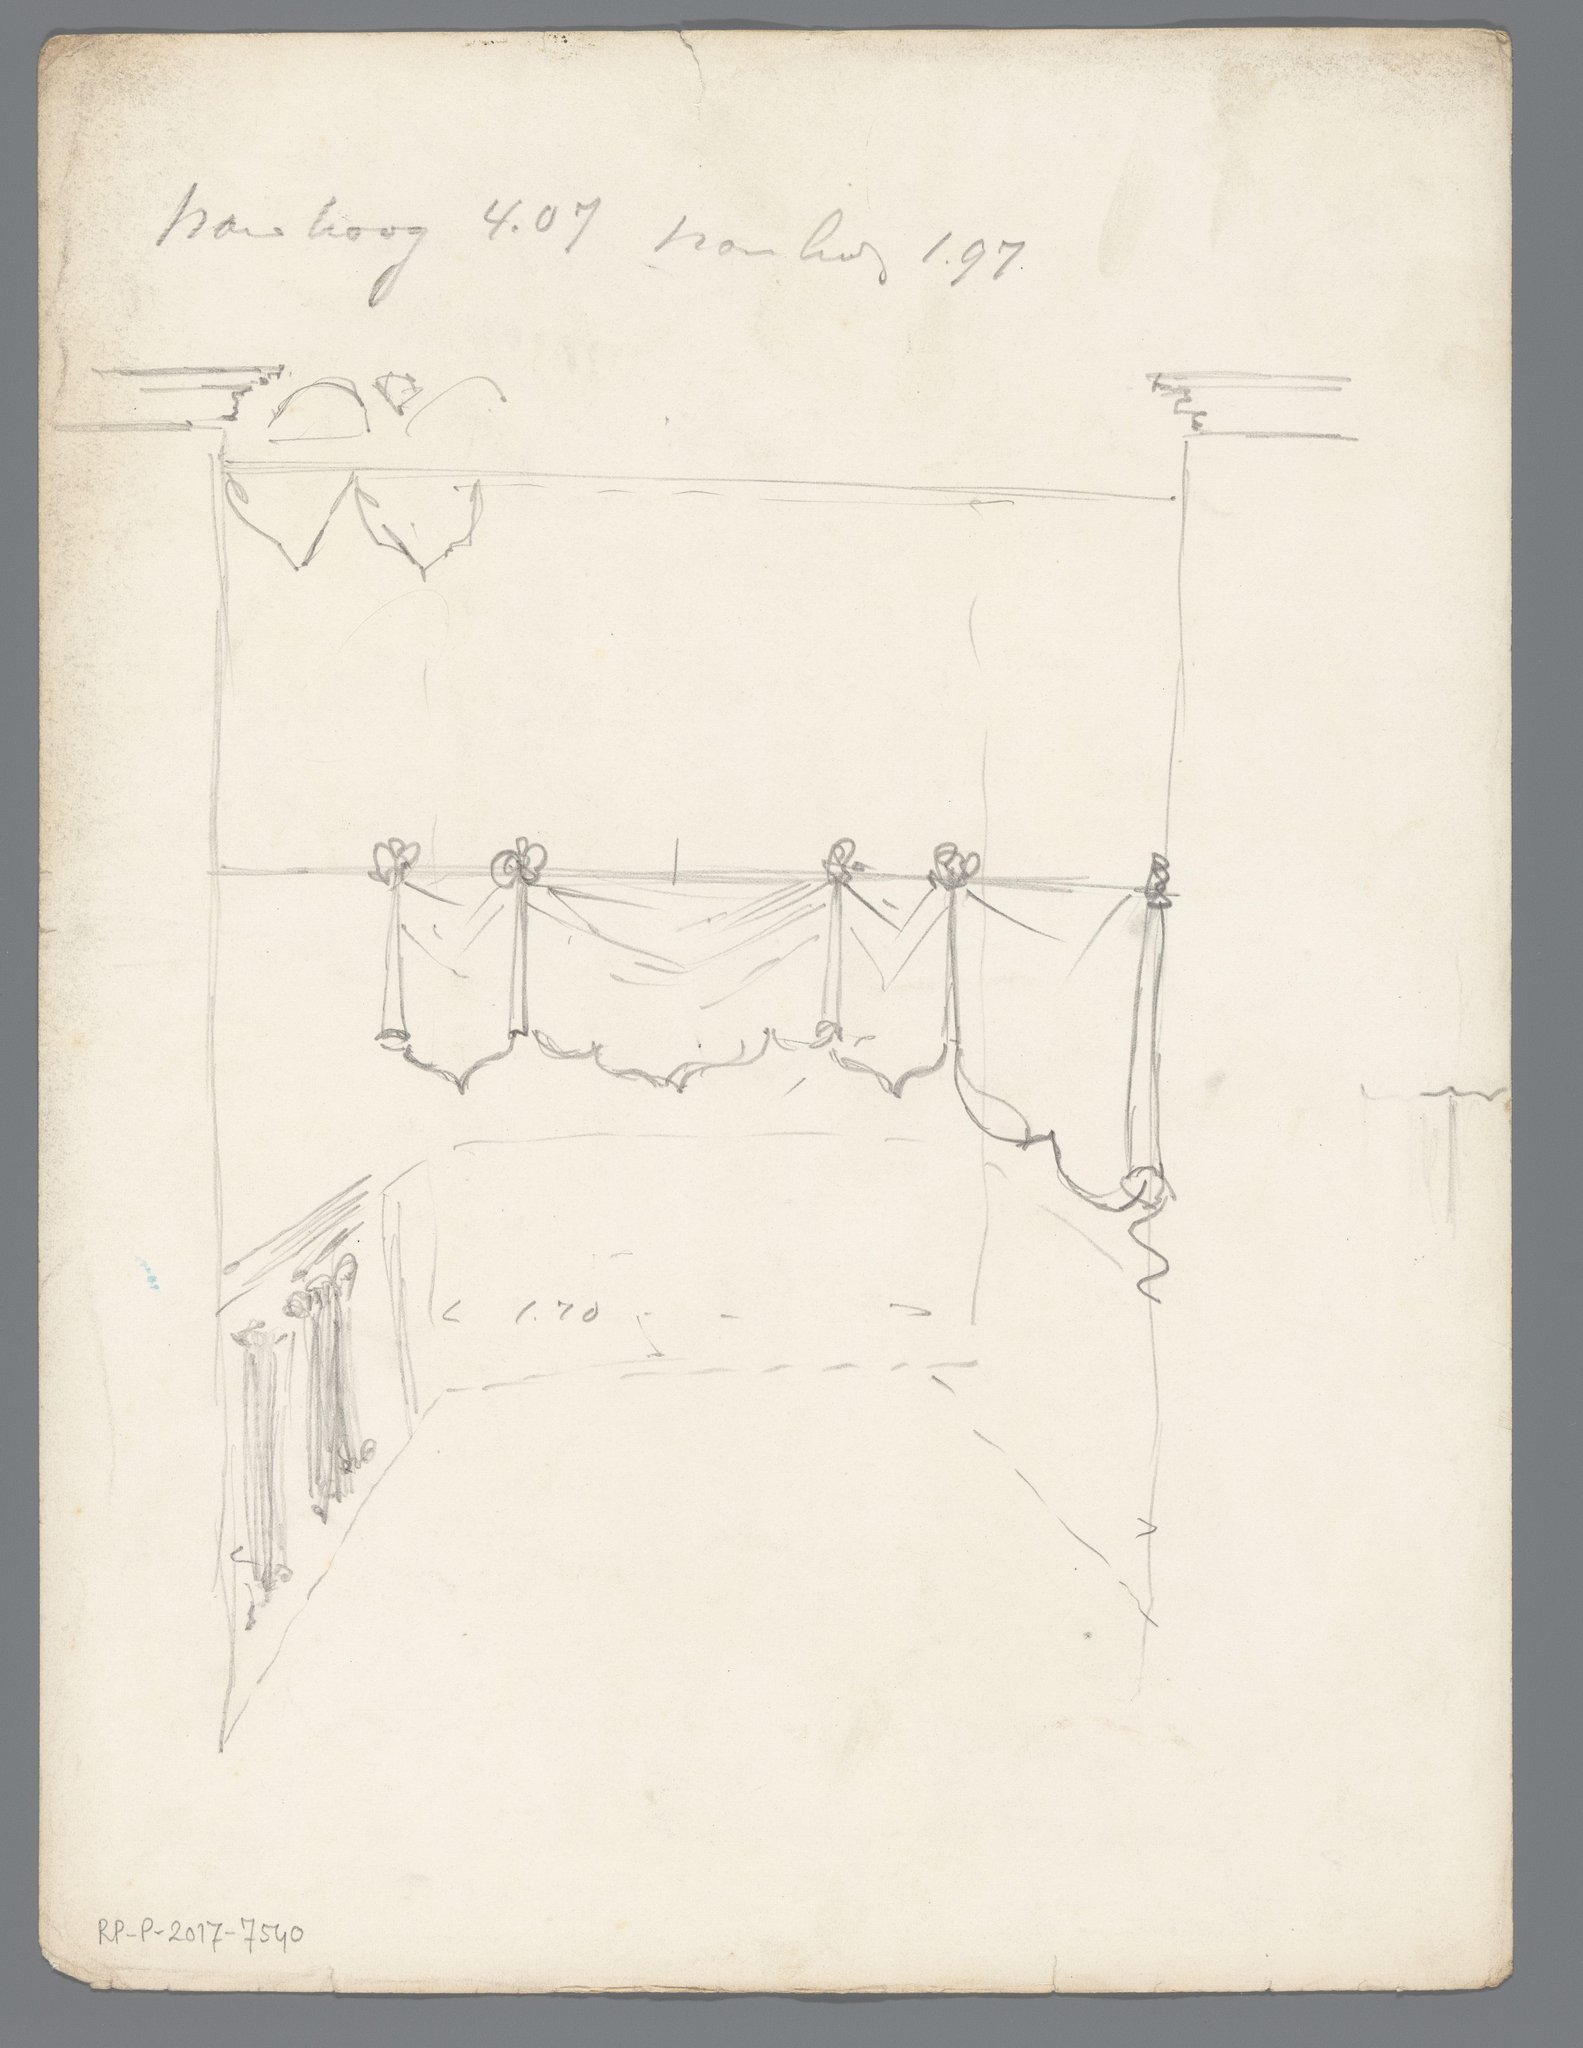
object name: drawing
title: Alkoof met draperieën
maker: Anonymous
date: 1886-1899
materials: paper, pencil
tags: decorations (interior of the house), hangings and drapery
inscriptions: annotation: ‘[...] hoog 4.07 [...] hoog 1.97’